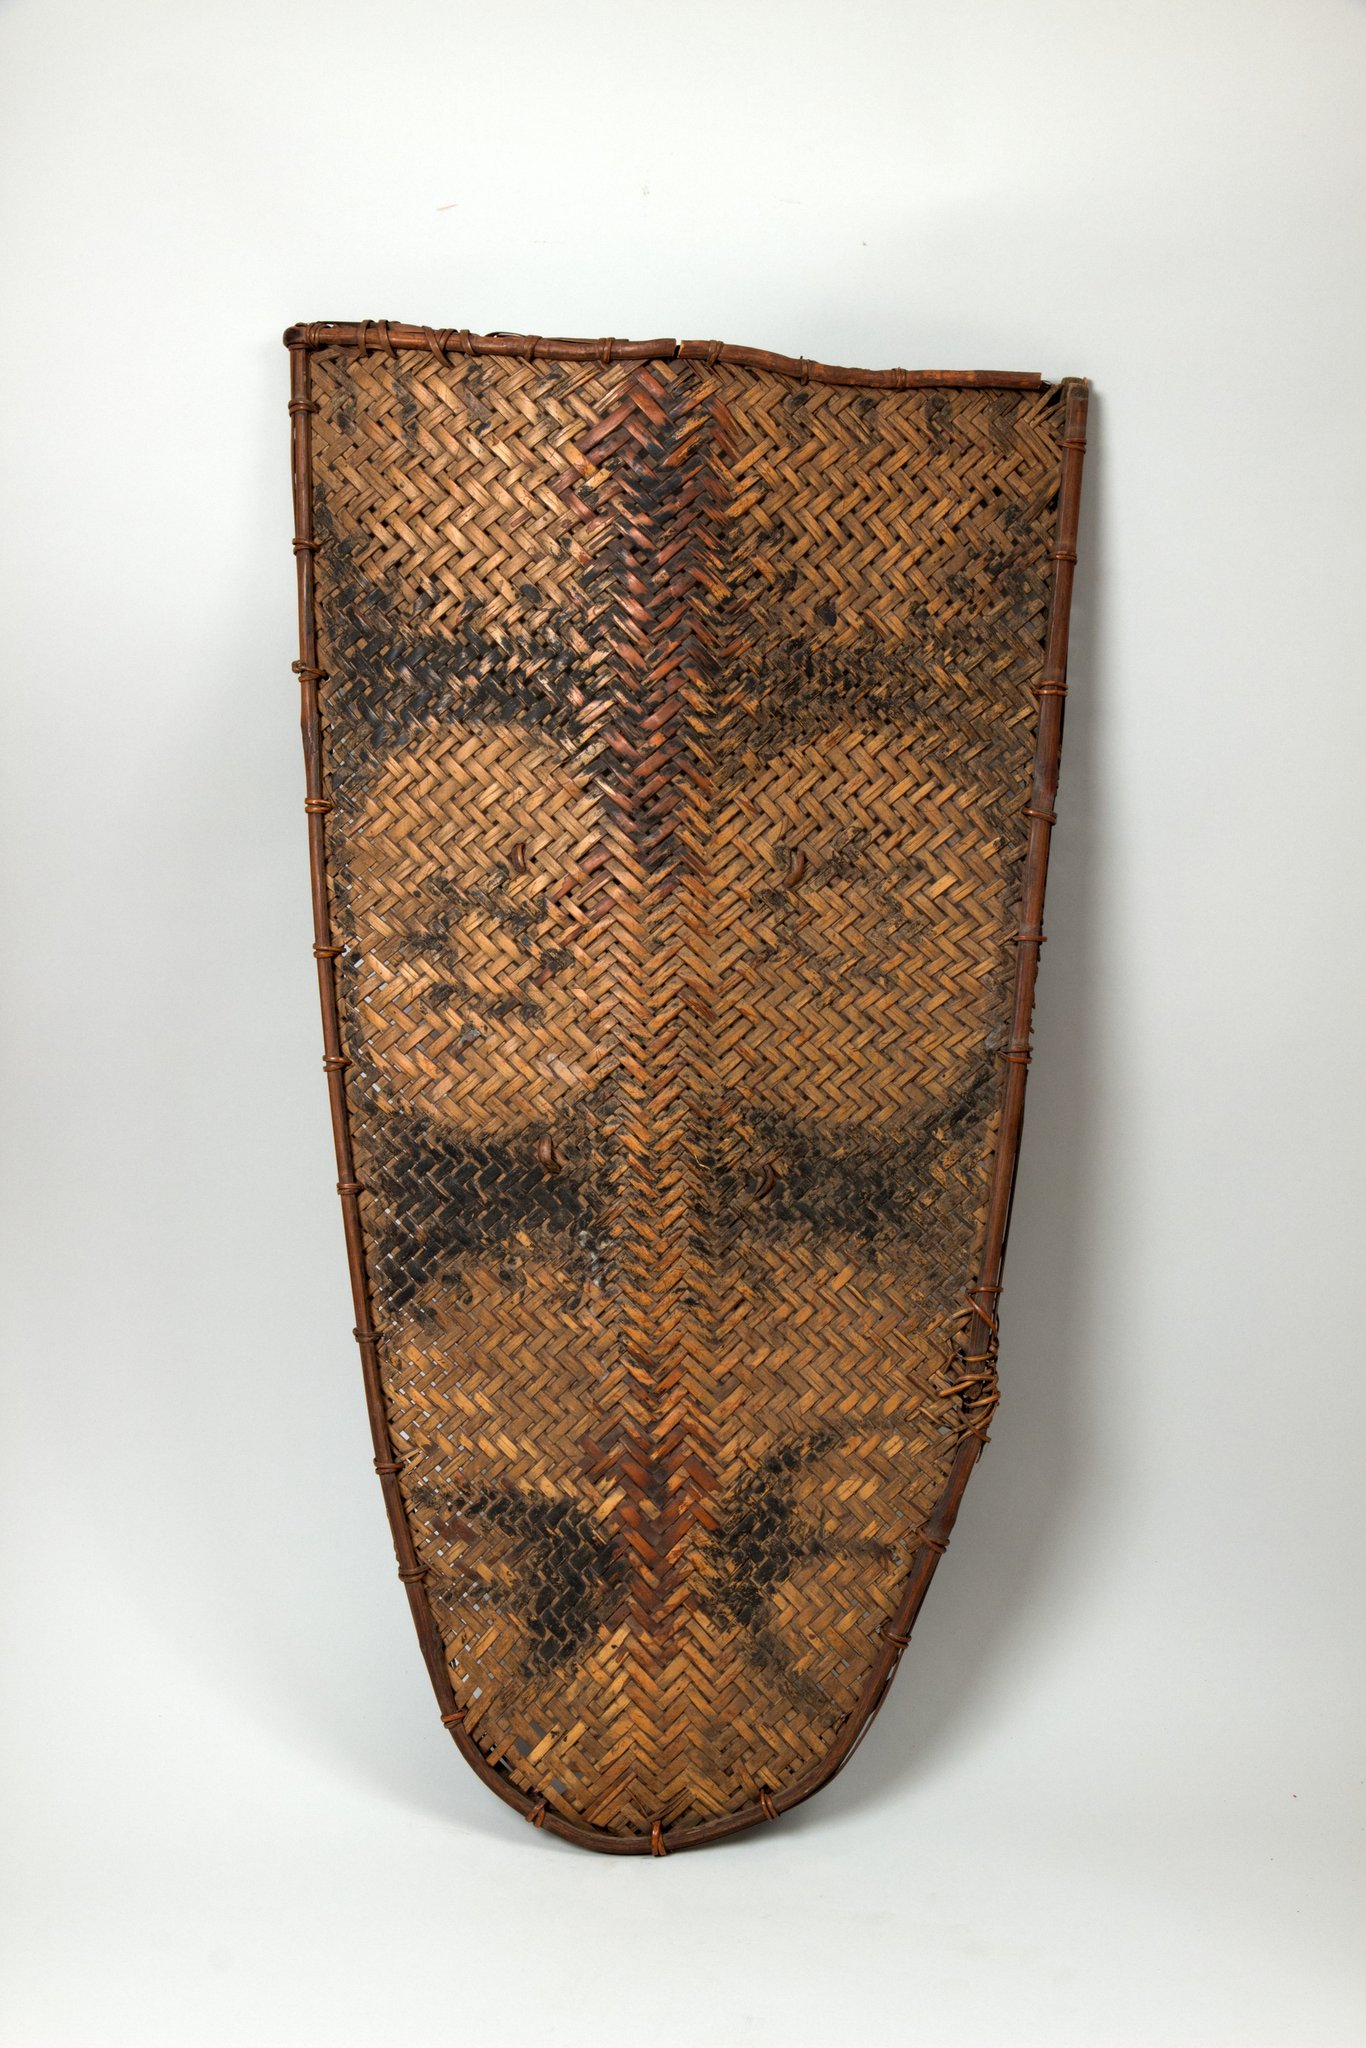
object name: shield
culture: indian, assam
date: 1801-1900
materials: bamboo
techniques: polychromy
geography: india